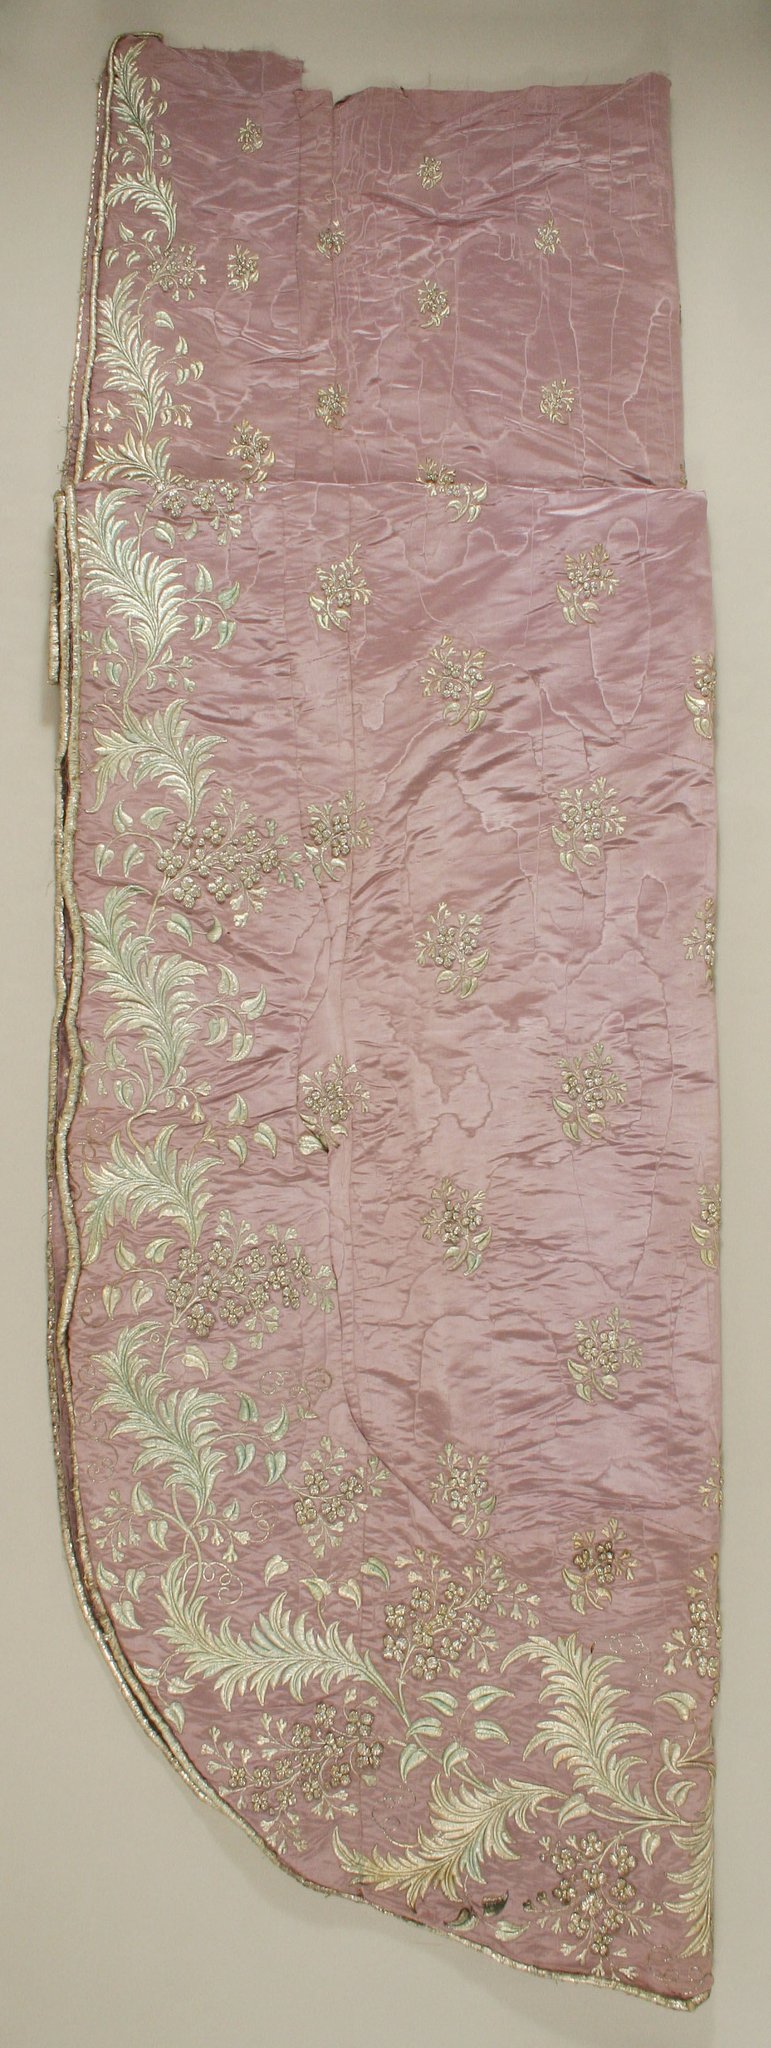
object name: train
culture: french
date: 1850-1859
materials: silk